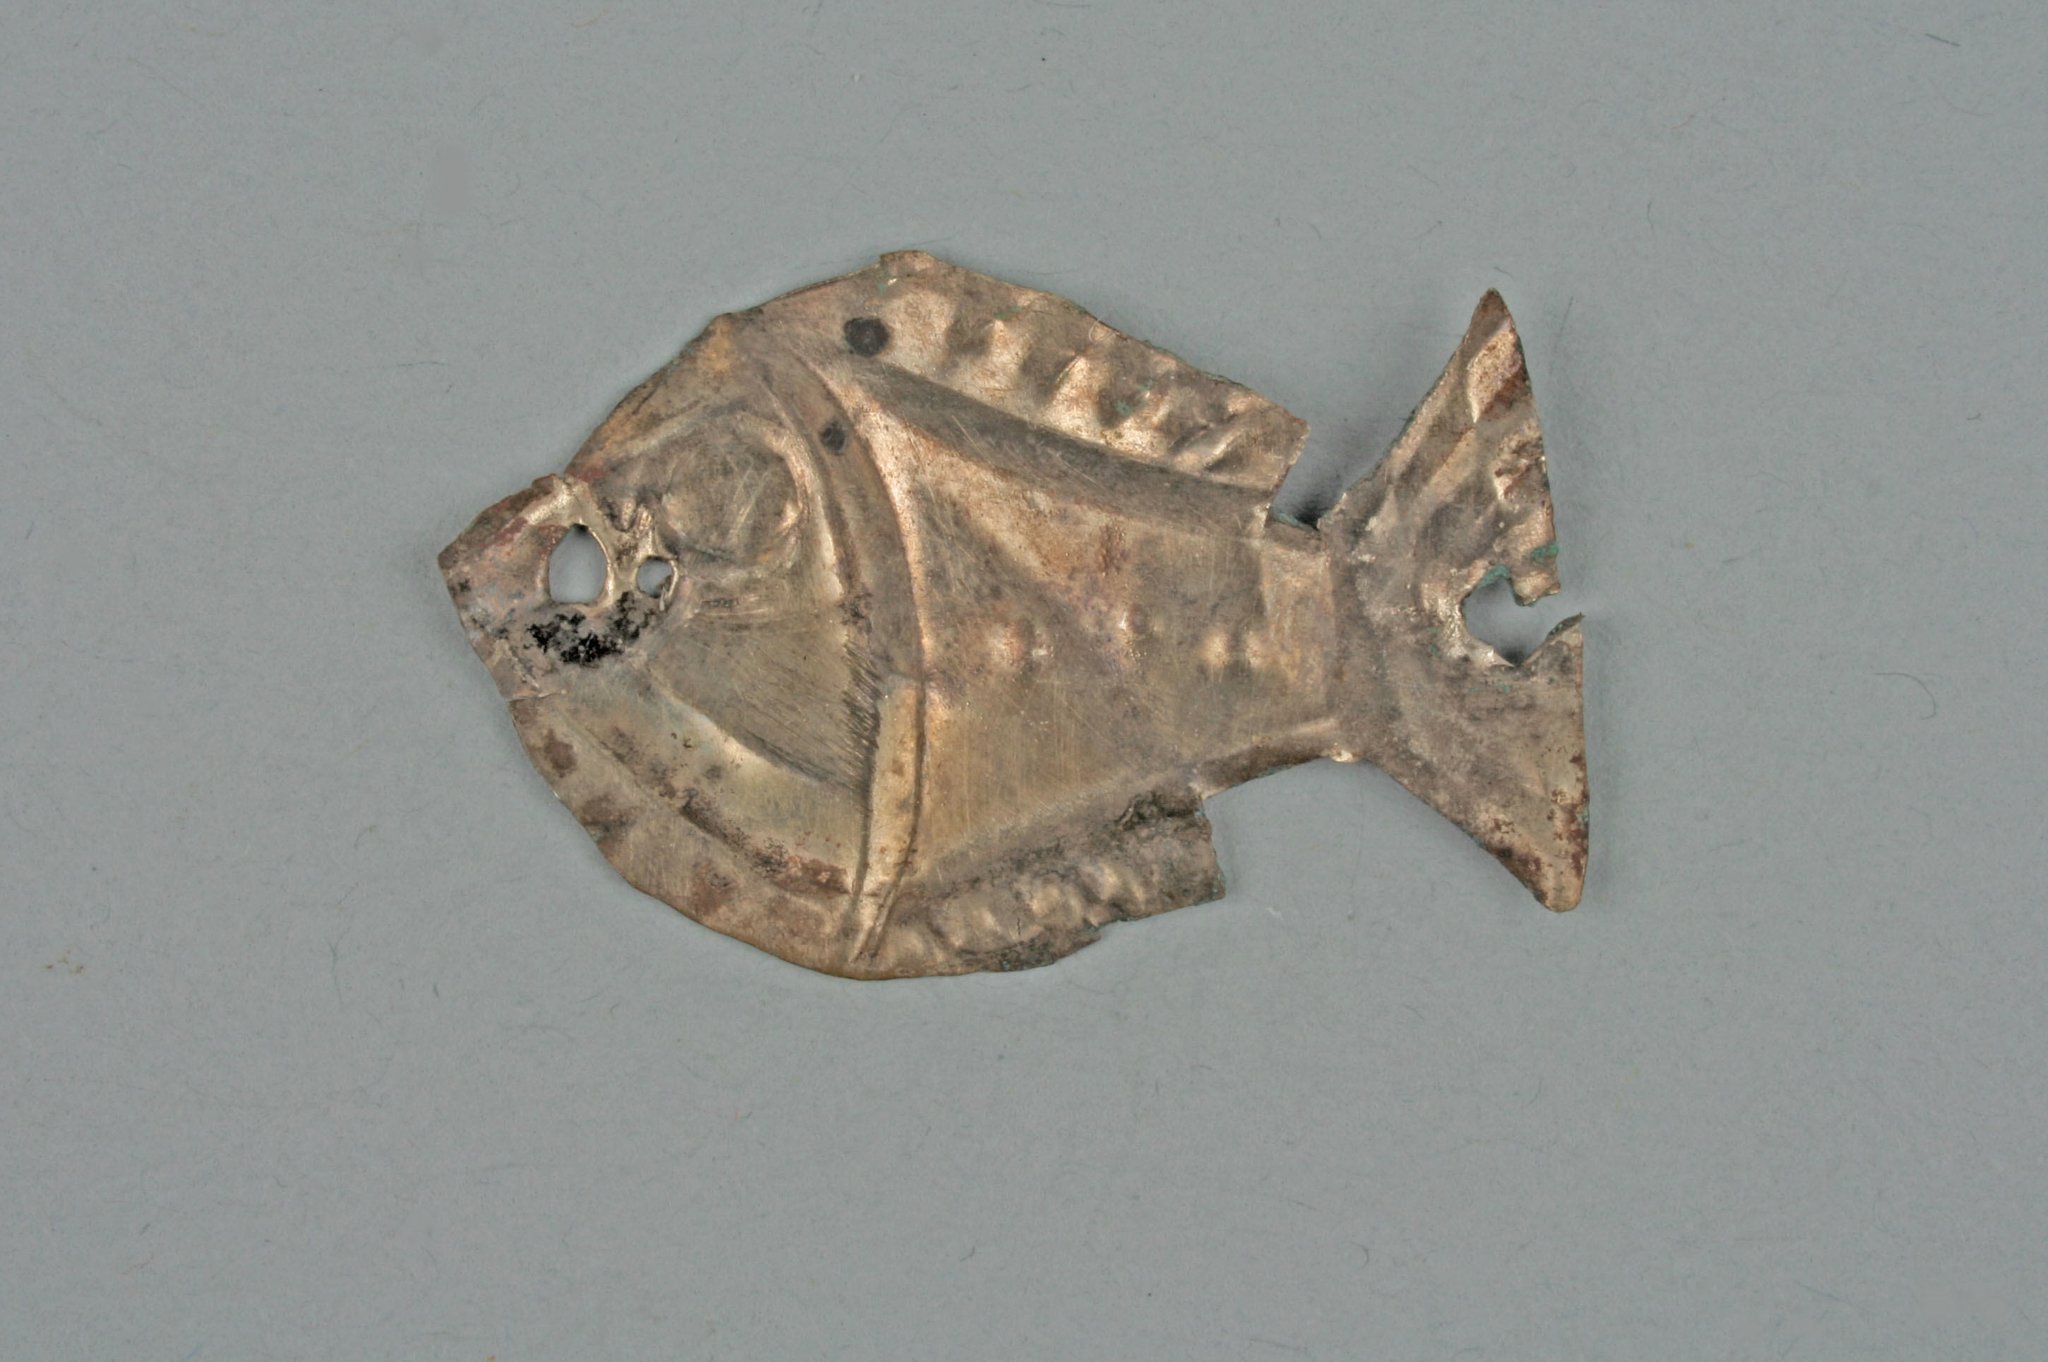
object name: ornament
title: Fish Ornament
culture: peruvian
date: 1001-1200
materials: silver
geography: peru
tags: fish